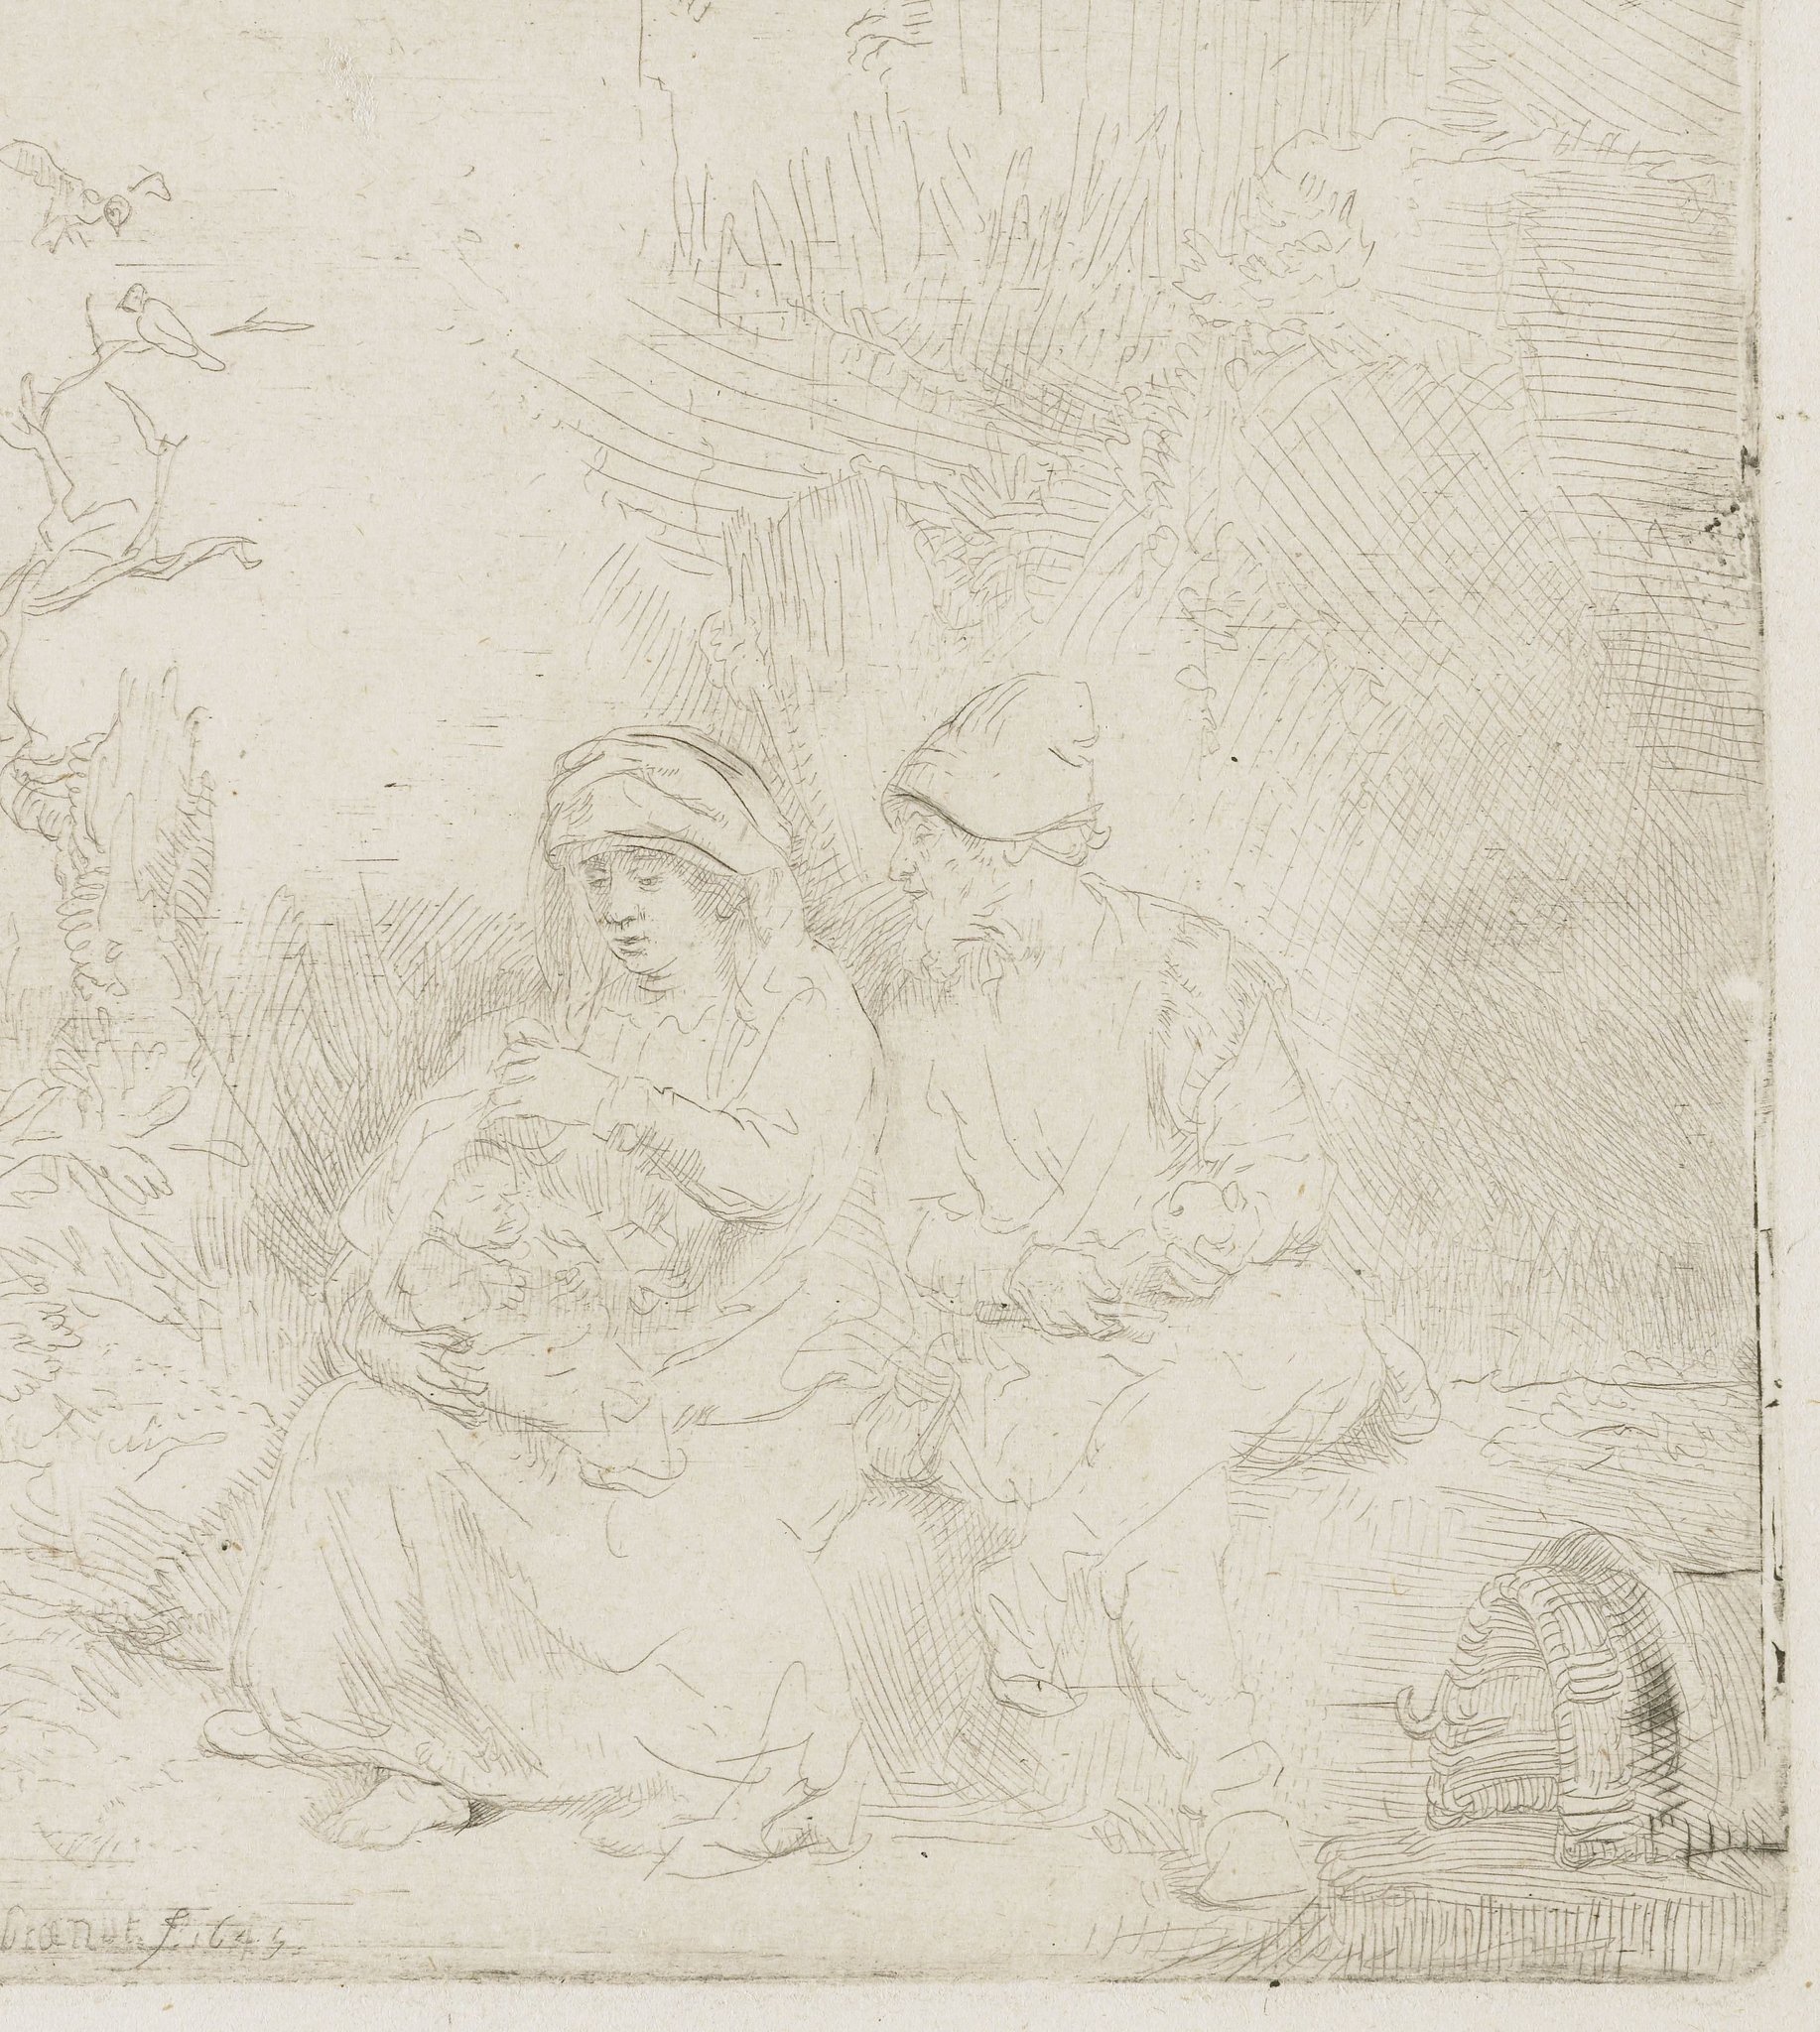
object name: print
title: The Rest on the Flight into Egypt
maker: rembrandt van rijn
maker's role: draughtsman, painter, print maker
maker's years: 1606-1669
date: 1645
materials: paper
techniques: drypoint, etching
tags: rest on the flight into egypt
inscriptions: signature and date: ‘Rembrandt f.1645’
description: This version stands out because Rembrandt defined the scene in outlines and let the acid bite the lines in the plate ever so lightly. Consequently, the print greatly resembles a silverpoint drawing. The Virgin shelters the sleeping Jesus from the sun, while Joseph looks on tenderly and peels an apple. Their donkey is outside the picture plane, its saddle just visible at lower right.